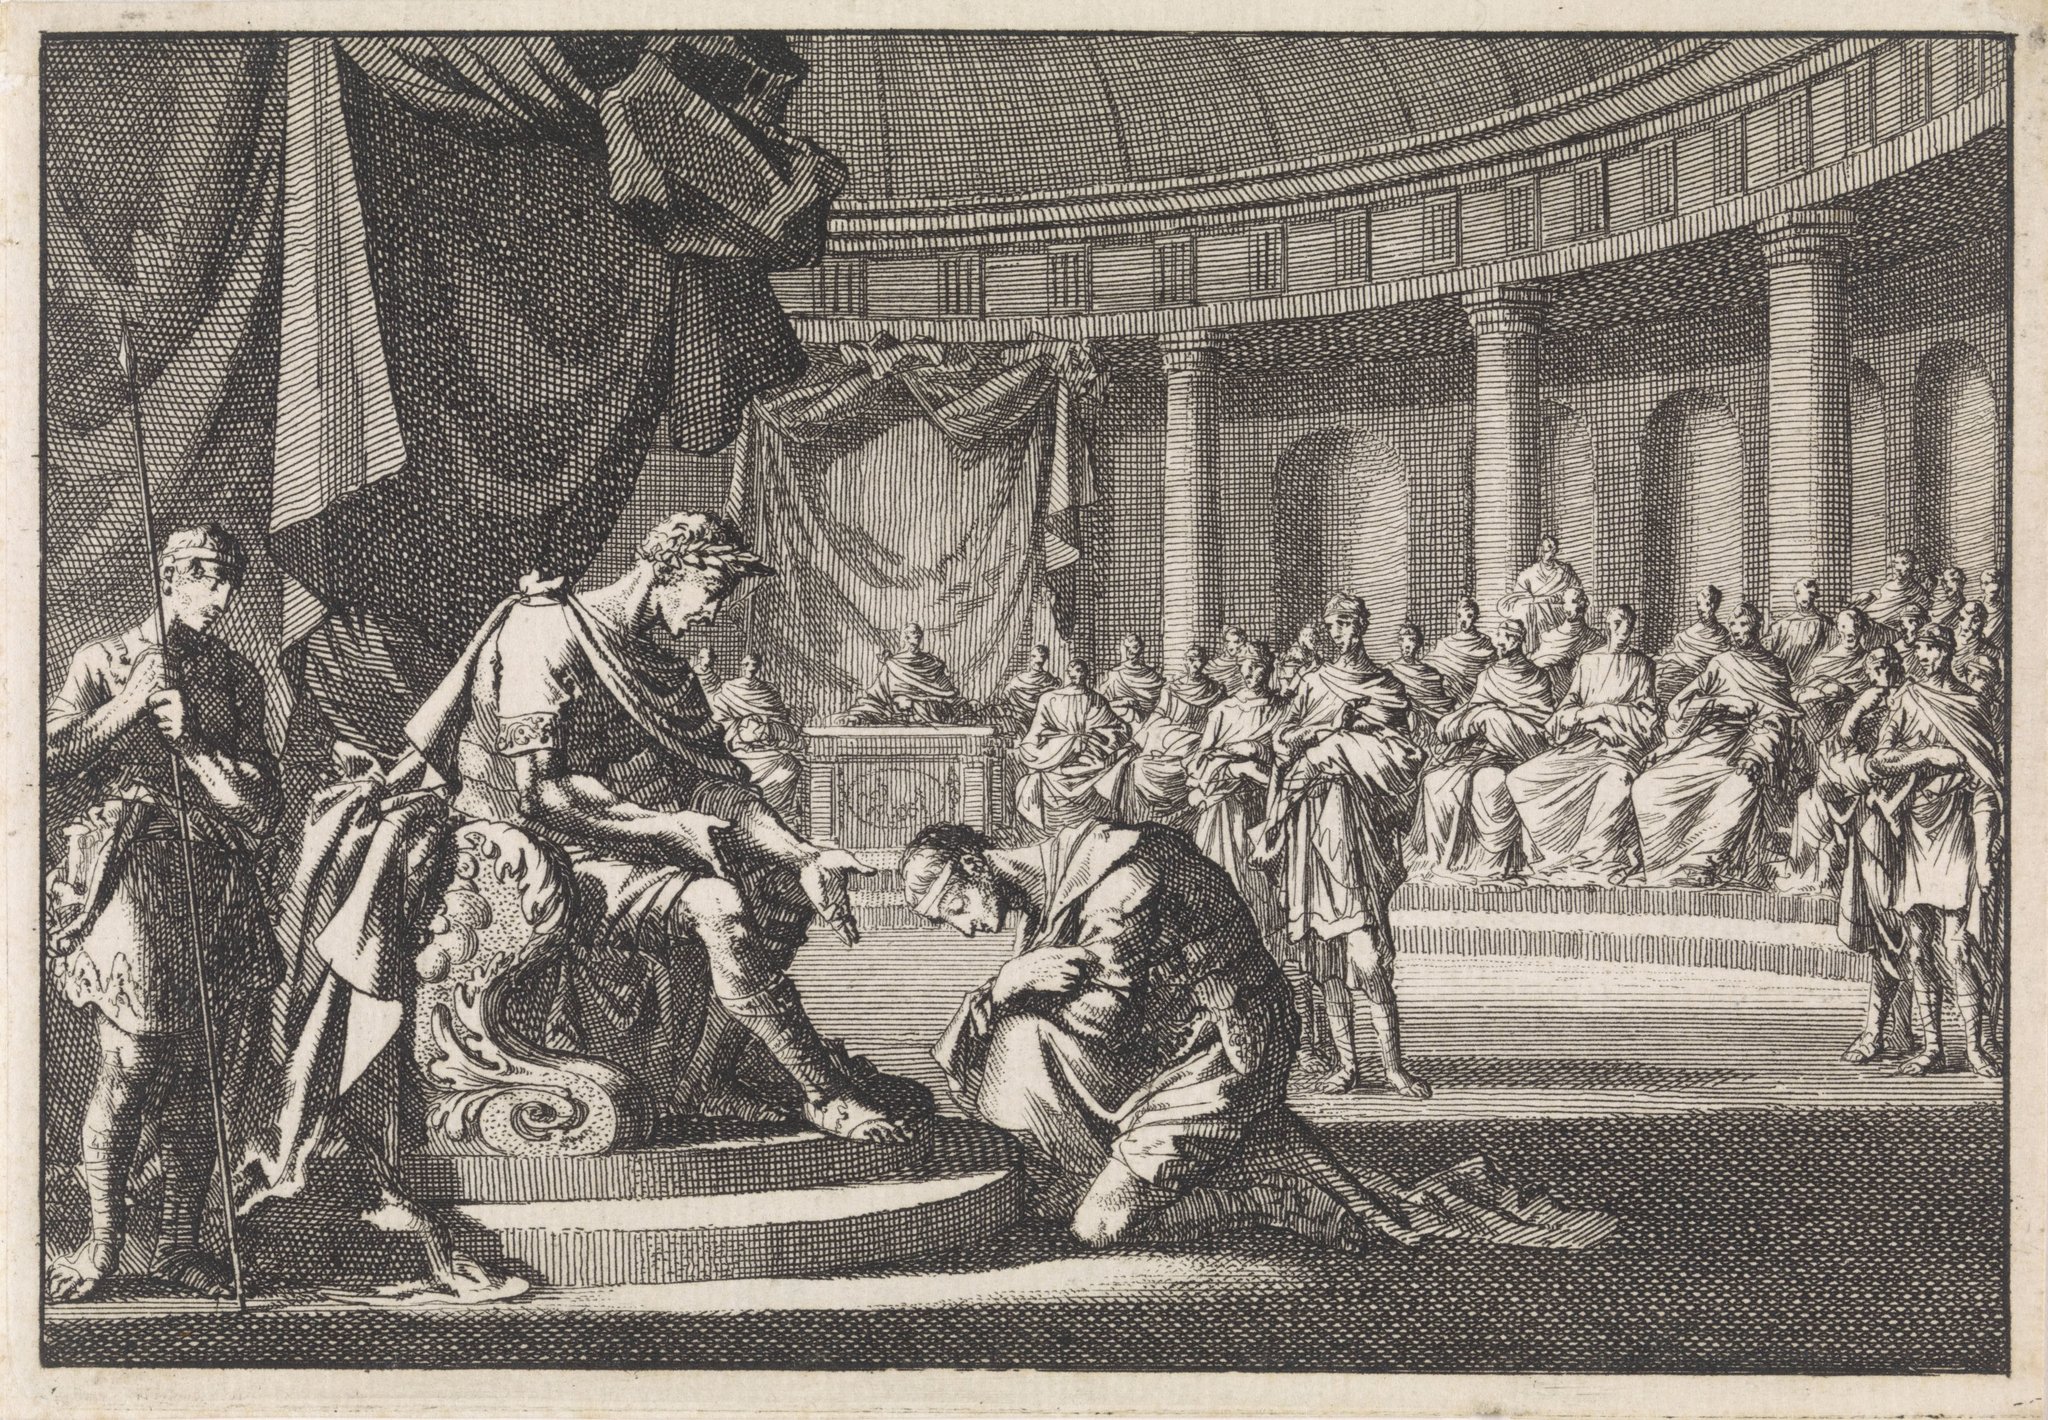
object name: print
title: Archelaüs, zoon van Herodes, knielt te Rome voor keizer Augustus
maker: jan luyken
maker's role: draughtsman, print maker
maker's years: 1649-1712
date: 1704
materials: paper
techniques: etching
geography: amsterdam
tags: kneeling before a ruler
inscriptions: collector's mark: Lugt 2228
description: Prent ook gebruikt als boekillustratie in: Josephus, Flavius. Alle de Werken, 2 delen. Amsterdam: Pieter Mortier, 1704, dl. 1, p. 422.